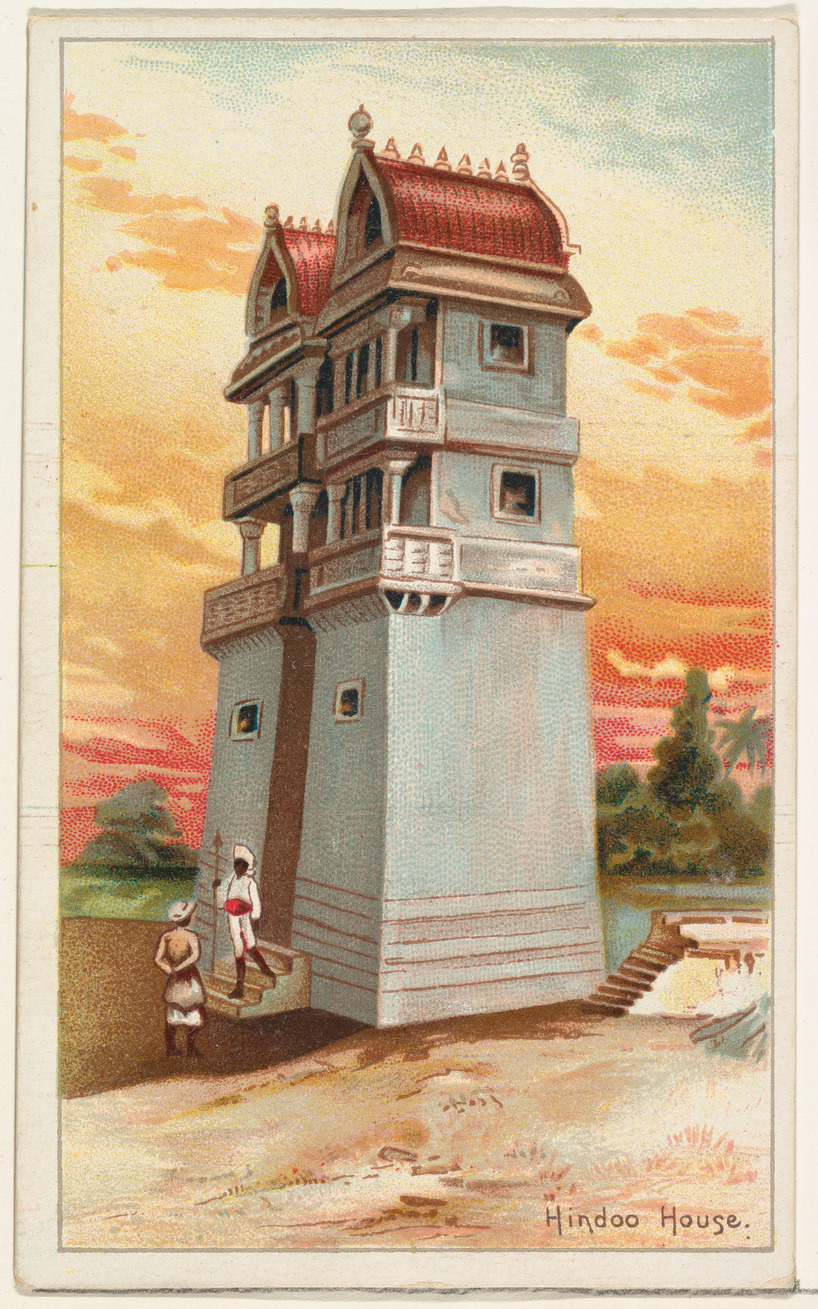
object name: print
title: Hindoo House, from the Habitations of Man series (N113) issued by W. Duke, Sons & Co. to promote Honest Long Cut Smoking and Chewing Tobacco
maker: the giles company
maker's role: artist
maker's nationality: american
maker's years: 1800-1900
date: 1890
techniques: color lithograph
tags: houses